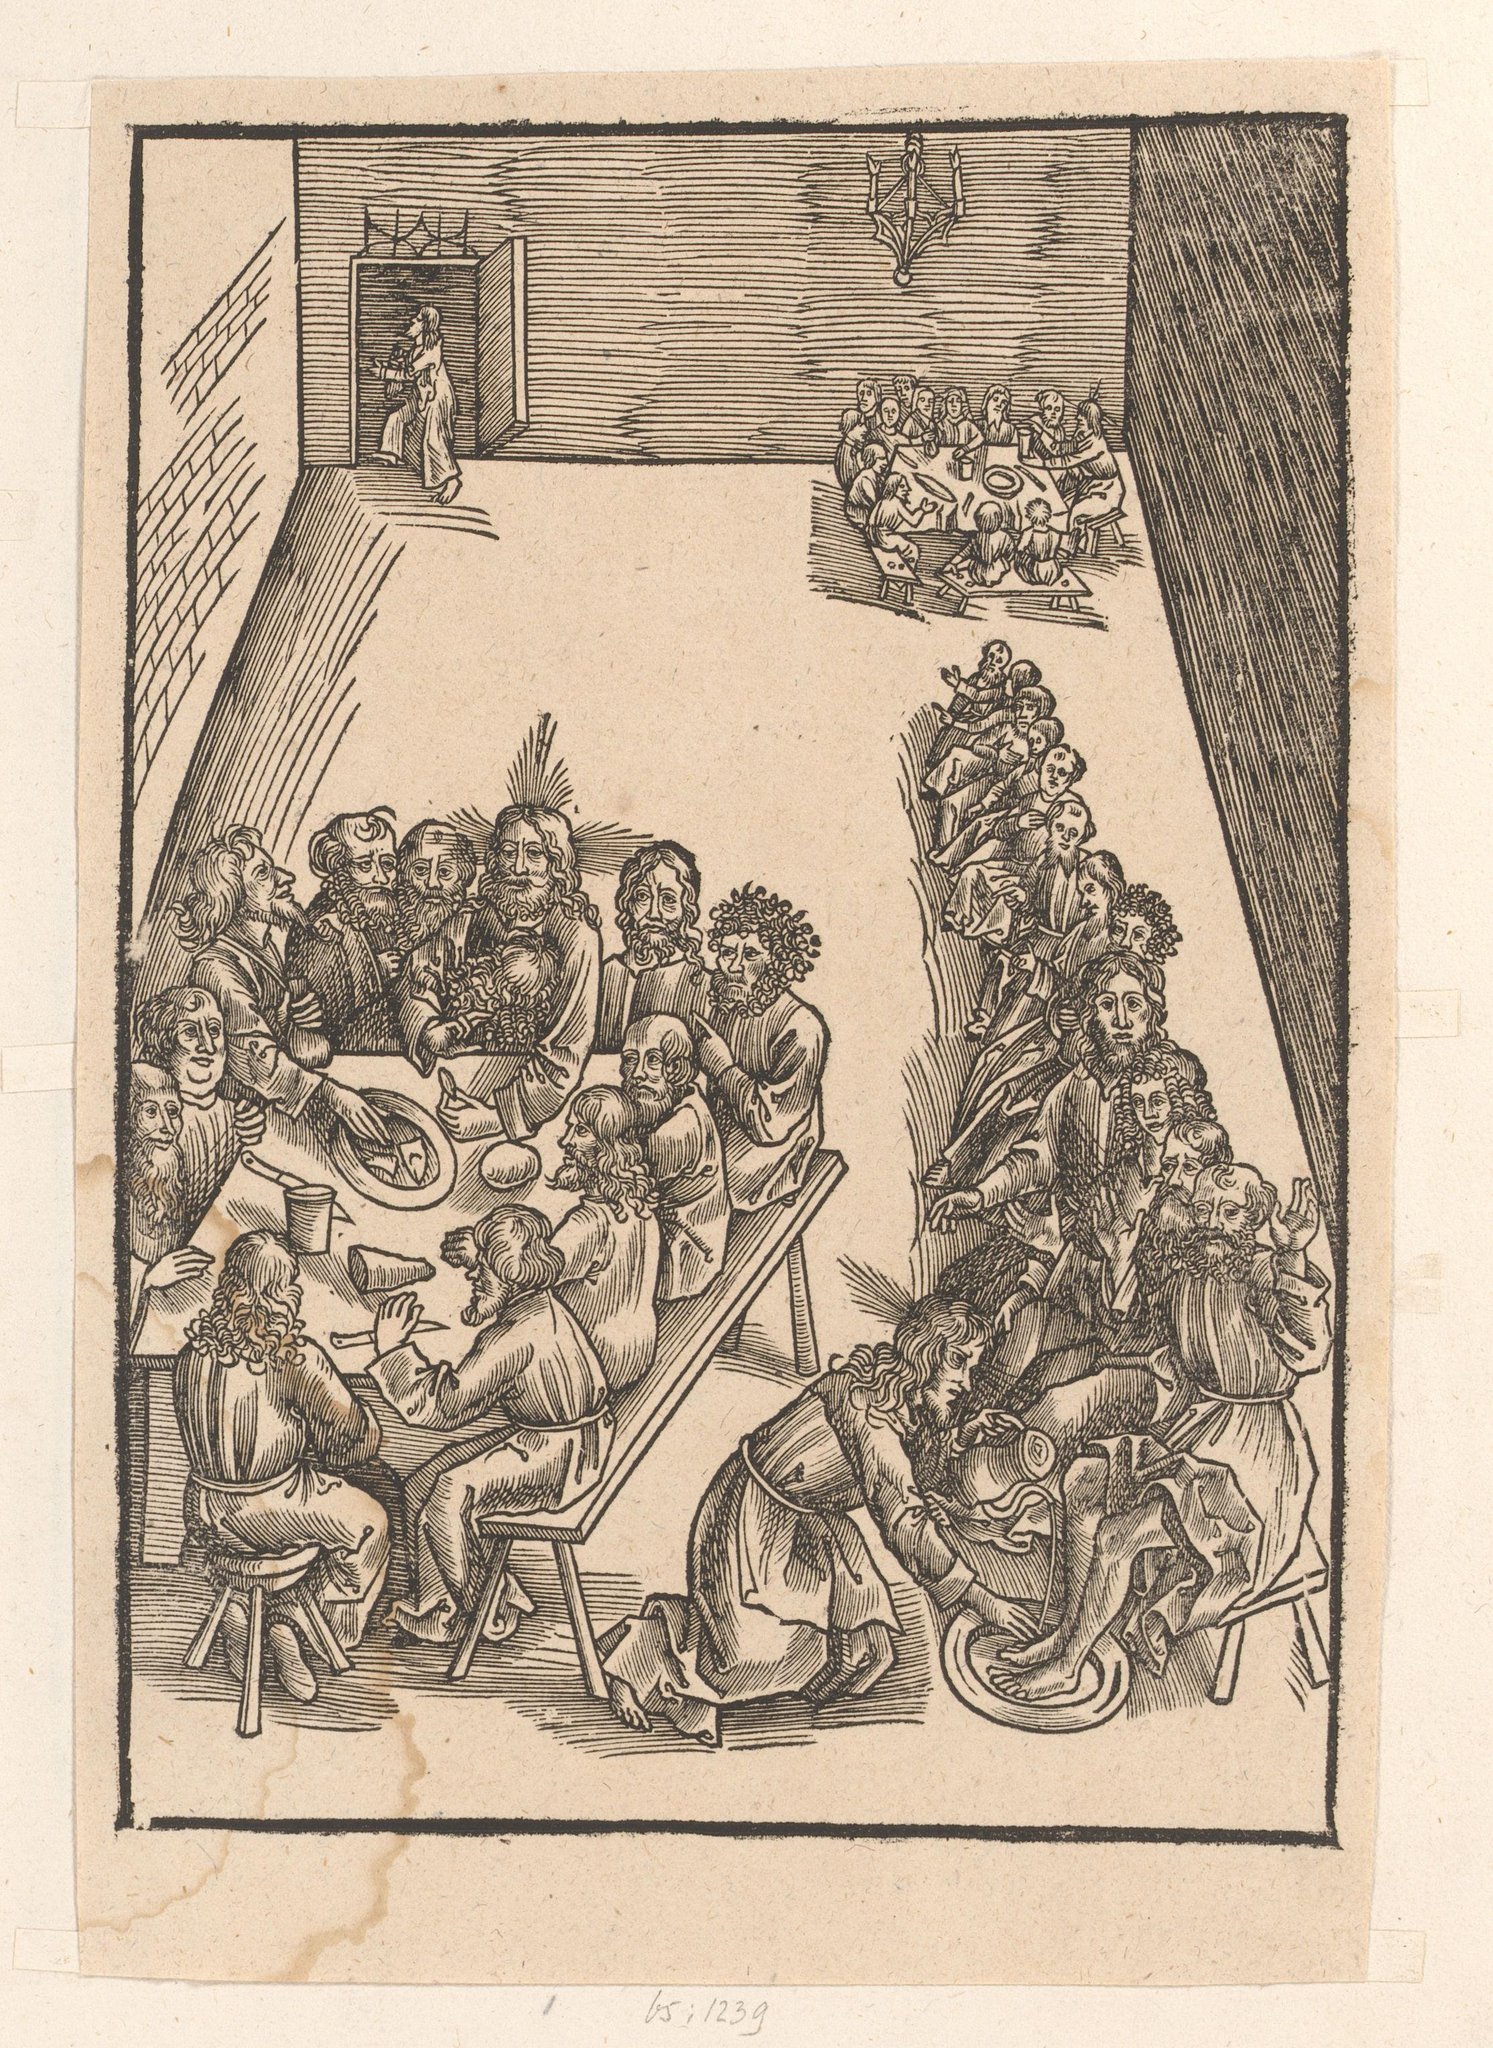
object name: print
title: Leven en passie van Christus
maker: urs graf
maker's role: draughtsman, print maker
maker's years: 1485-1528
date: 1506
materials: paper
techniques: woodcut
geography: switzerland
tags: christ washes peter's feet, last supper (in general) (matthew 26:21-35; mark 14:18-31; luke 22:3, 22:15-23; john 13:21-38)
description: Links Christus die het laatste avondmaal viert met zijn discipelen. Johannes legt zijn hoofd tegen de borst van Christus. Judas houdt de zak met zilverstukken in zijn hand. Links in de achtergrond vertrekt Judas. Rechts Christus die de voeten van Petrus wast. Petrus houdt zijn handen in de lucht, omdat hij voorstelt ook zijn handen en zijn hoofd te wassen. Achter Petrus zitten de andere discipelen op een rij op een bank. Prent maakt deel uit van een album.